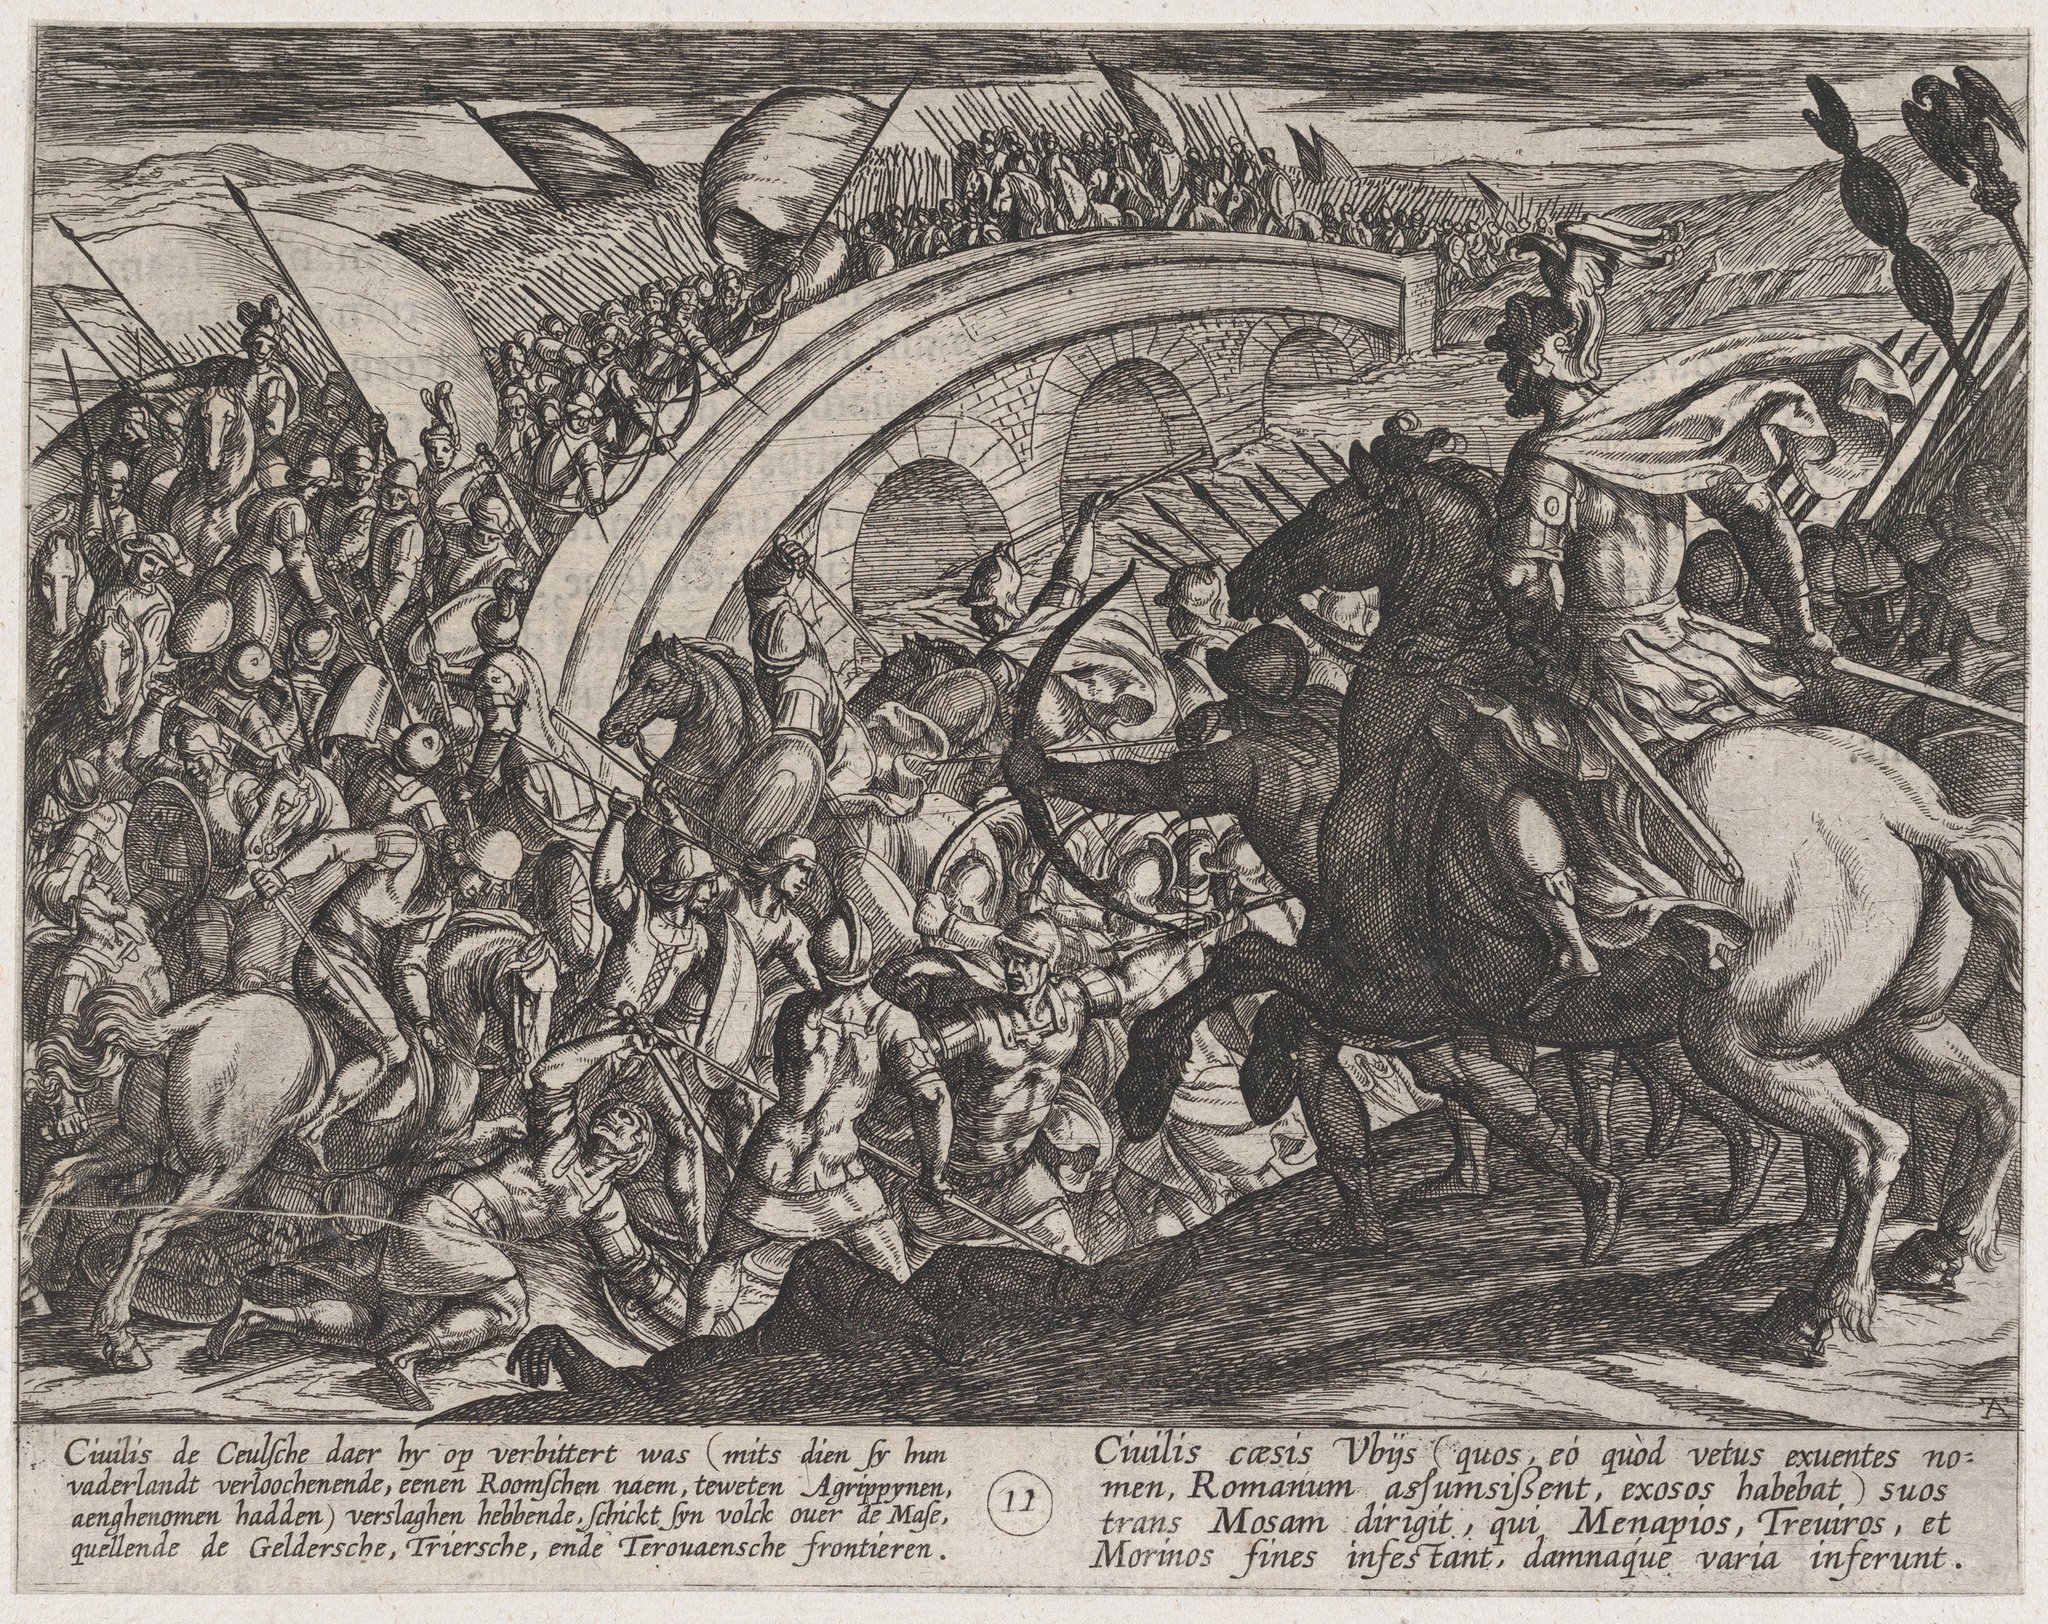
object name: print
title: Plate 11: Civilis' Troops Crossing the Maas River, from The War of the Romans Against the Batavians (Romanorvm et Batavorvm societas)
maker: antonio tempesta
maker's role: artist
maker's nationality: italian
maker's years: 1555-1630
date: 1611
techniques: etching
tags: bridges,wars,men,horses,rivers